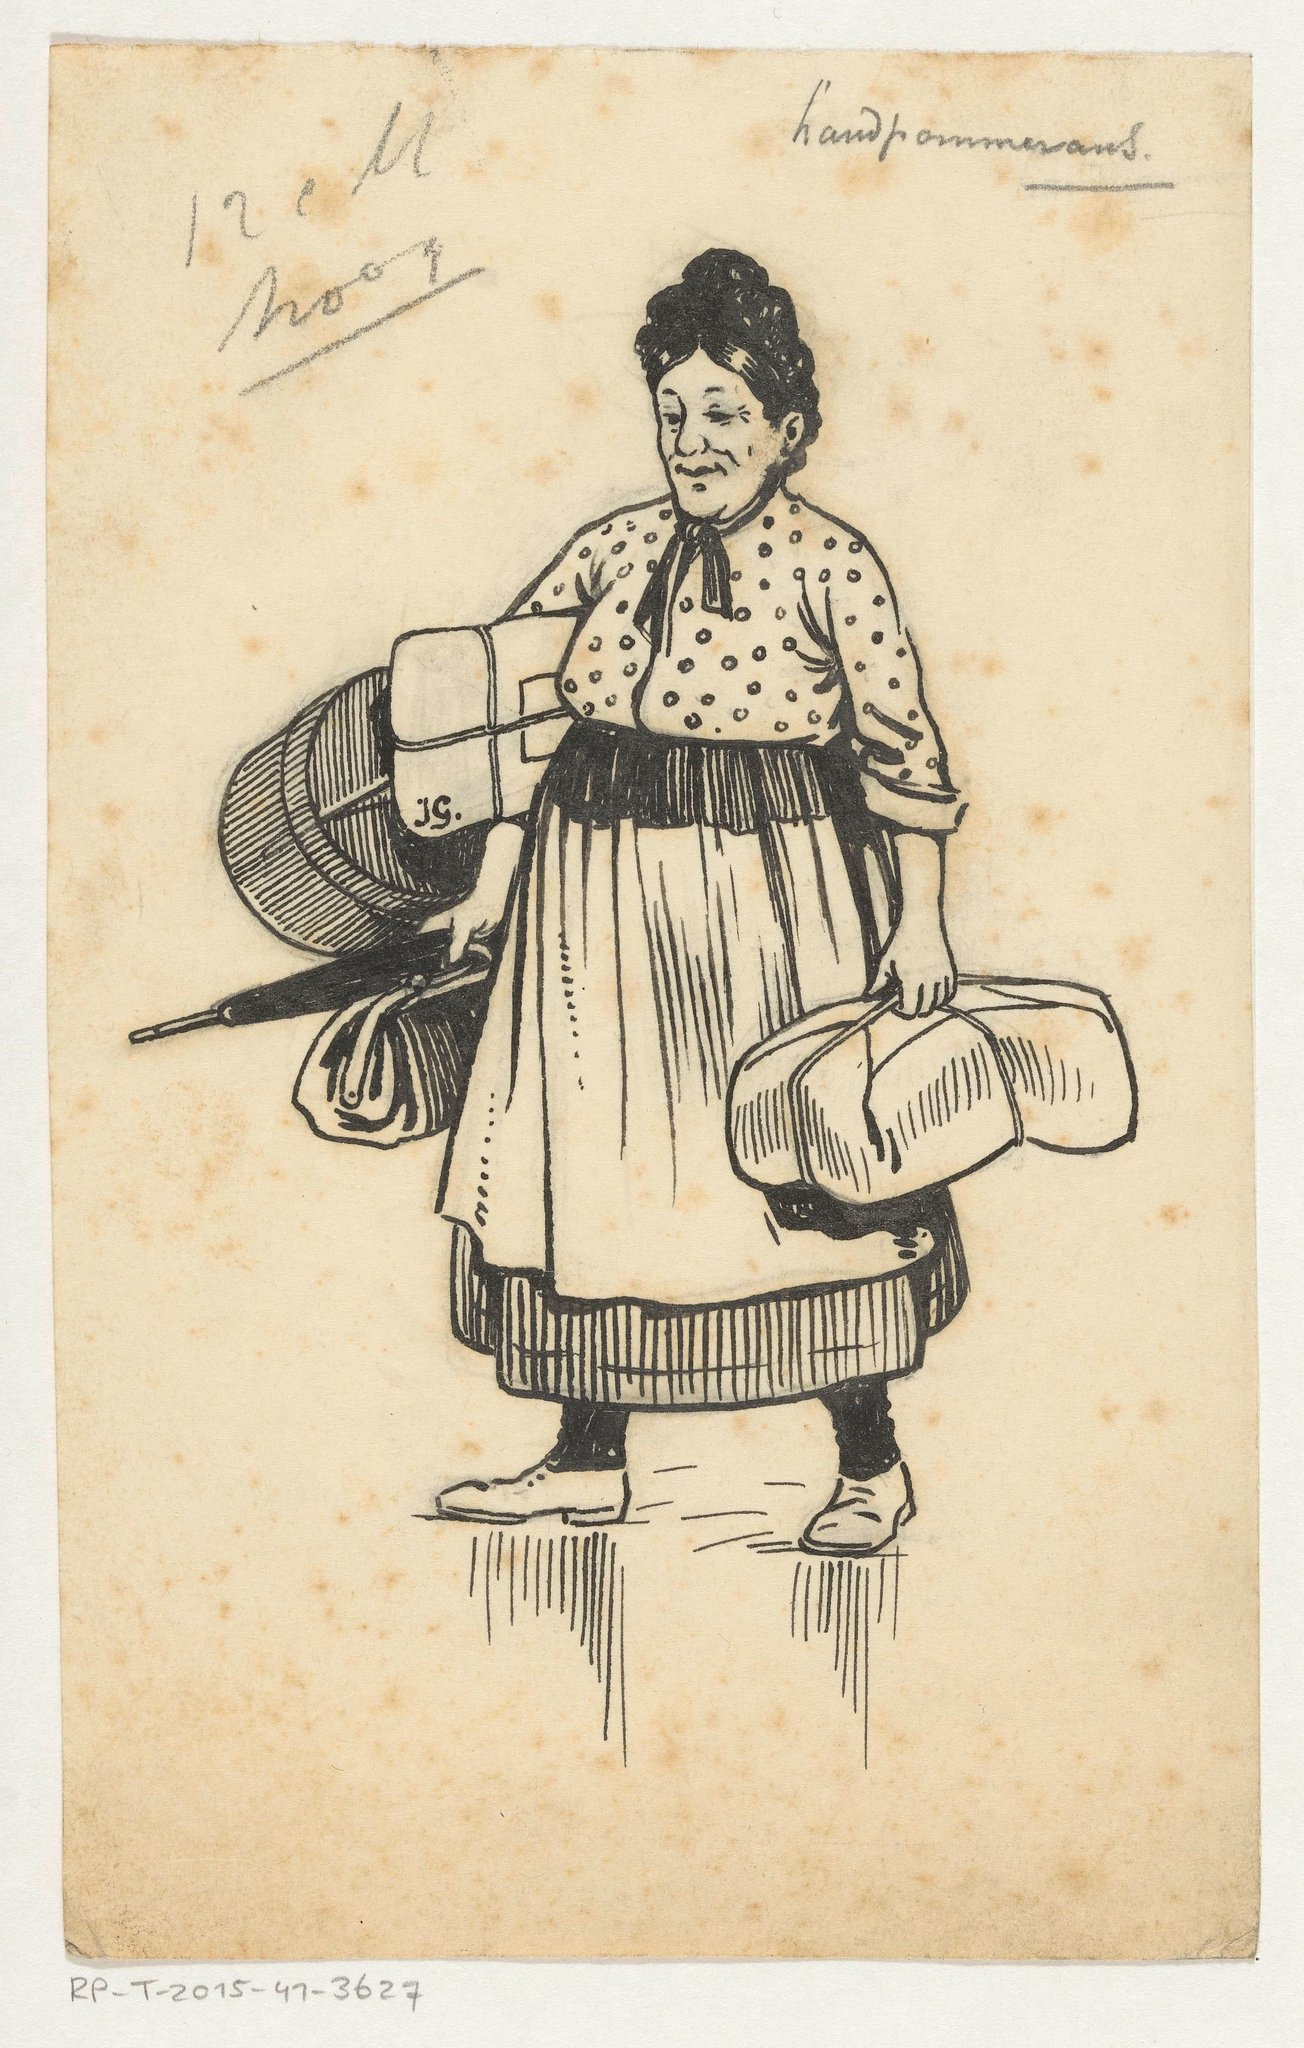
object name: drawing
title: Vrouw met reisgoed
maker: Anonymous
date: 1900-1940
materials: ink, paper, pencil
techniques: pen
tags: luggage, travel requisites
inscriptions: collector's mark: Lugt 2228a, signature: ‘JG.’, annotation: ‘Landpommerans.’, :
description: Een vrouw in een gestipte blouse met een schort voor haar rok draagt tassen, pakketten en een paraplu.